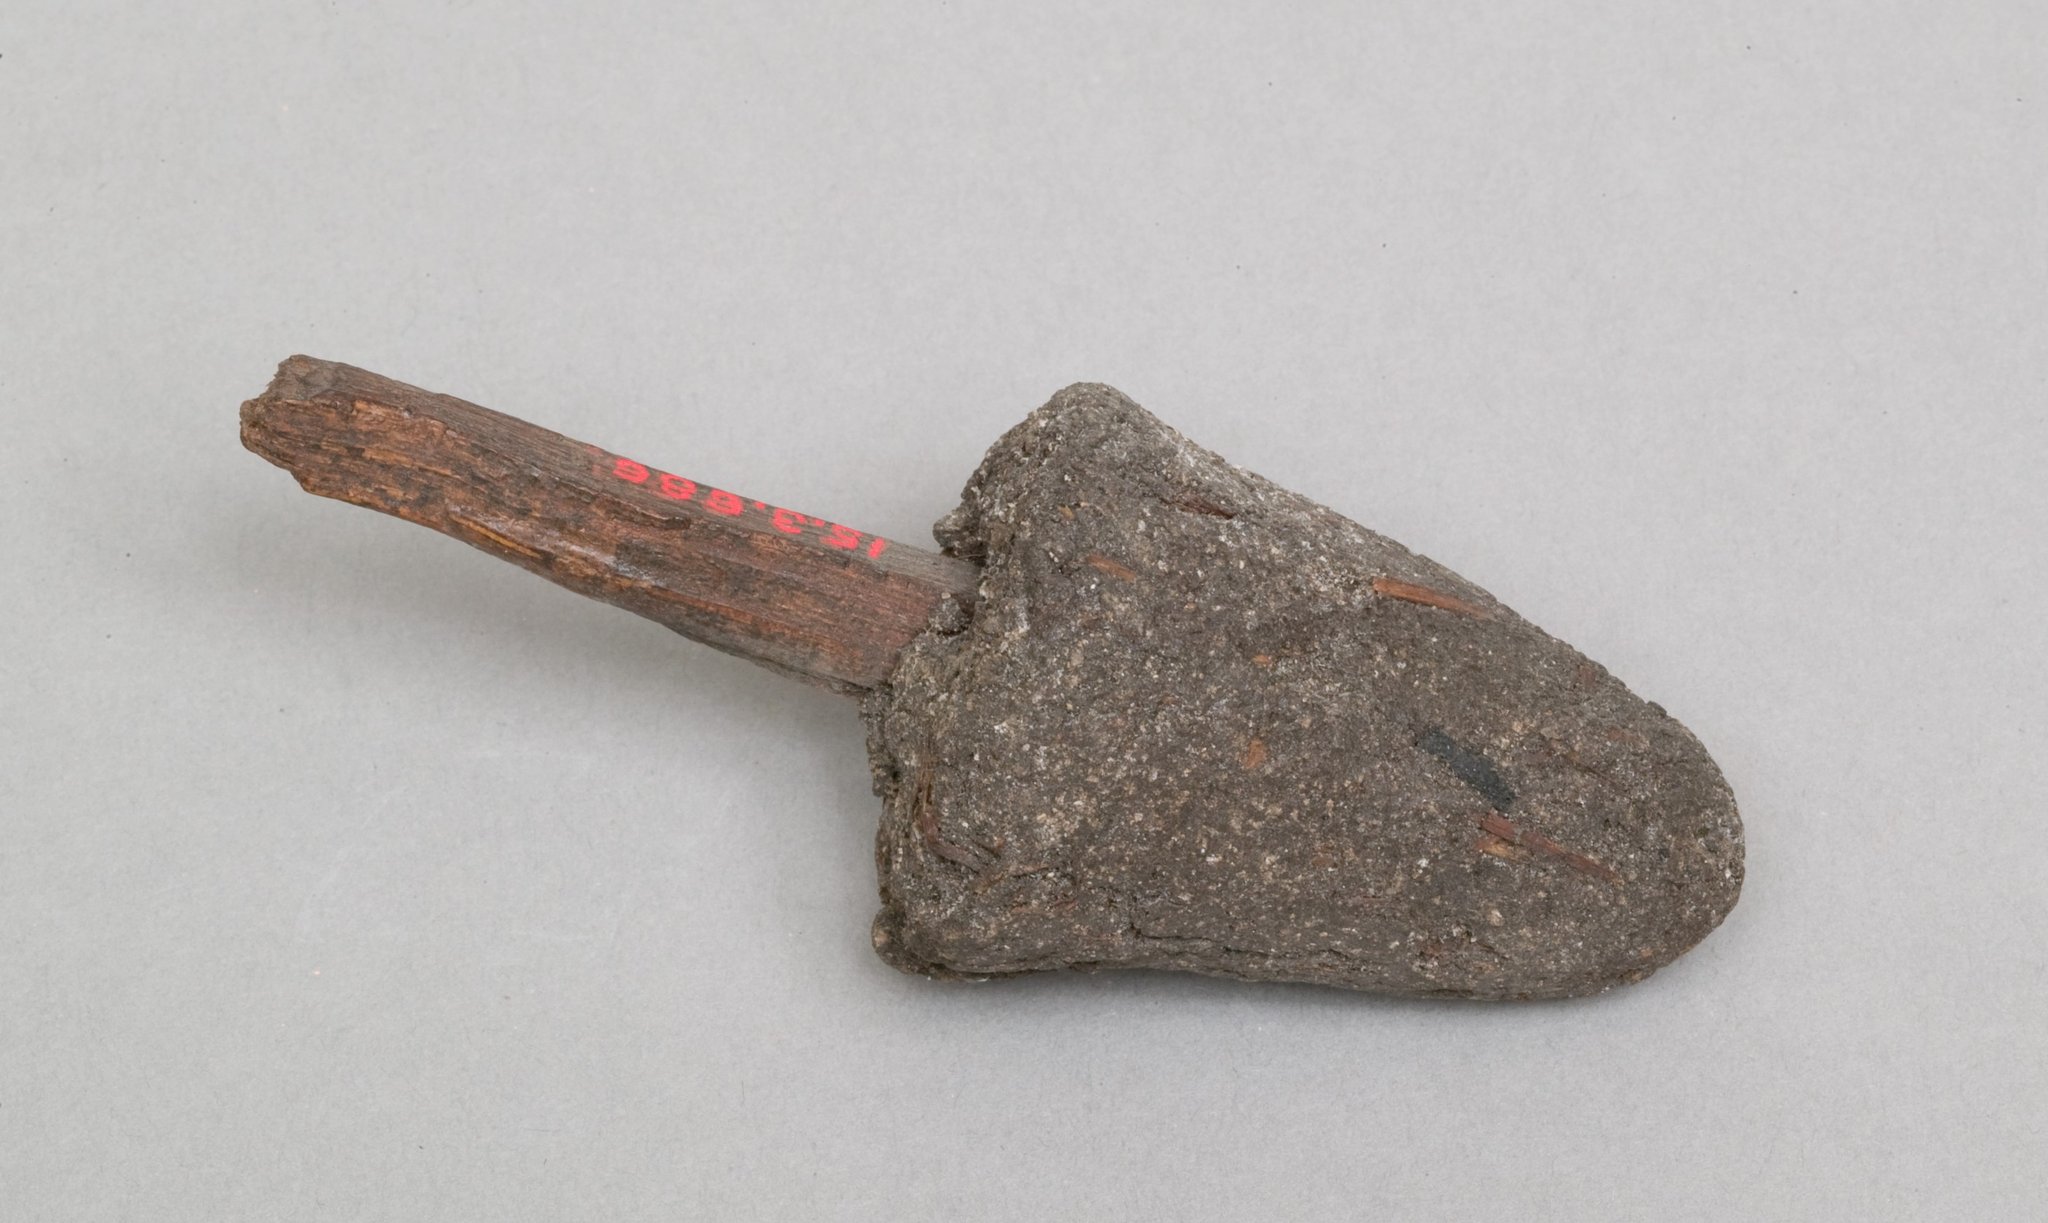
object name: spindle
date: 1295-1070 BCE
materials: mud, wood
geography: egypt